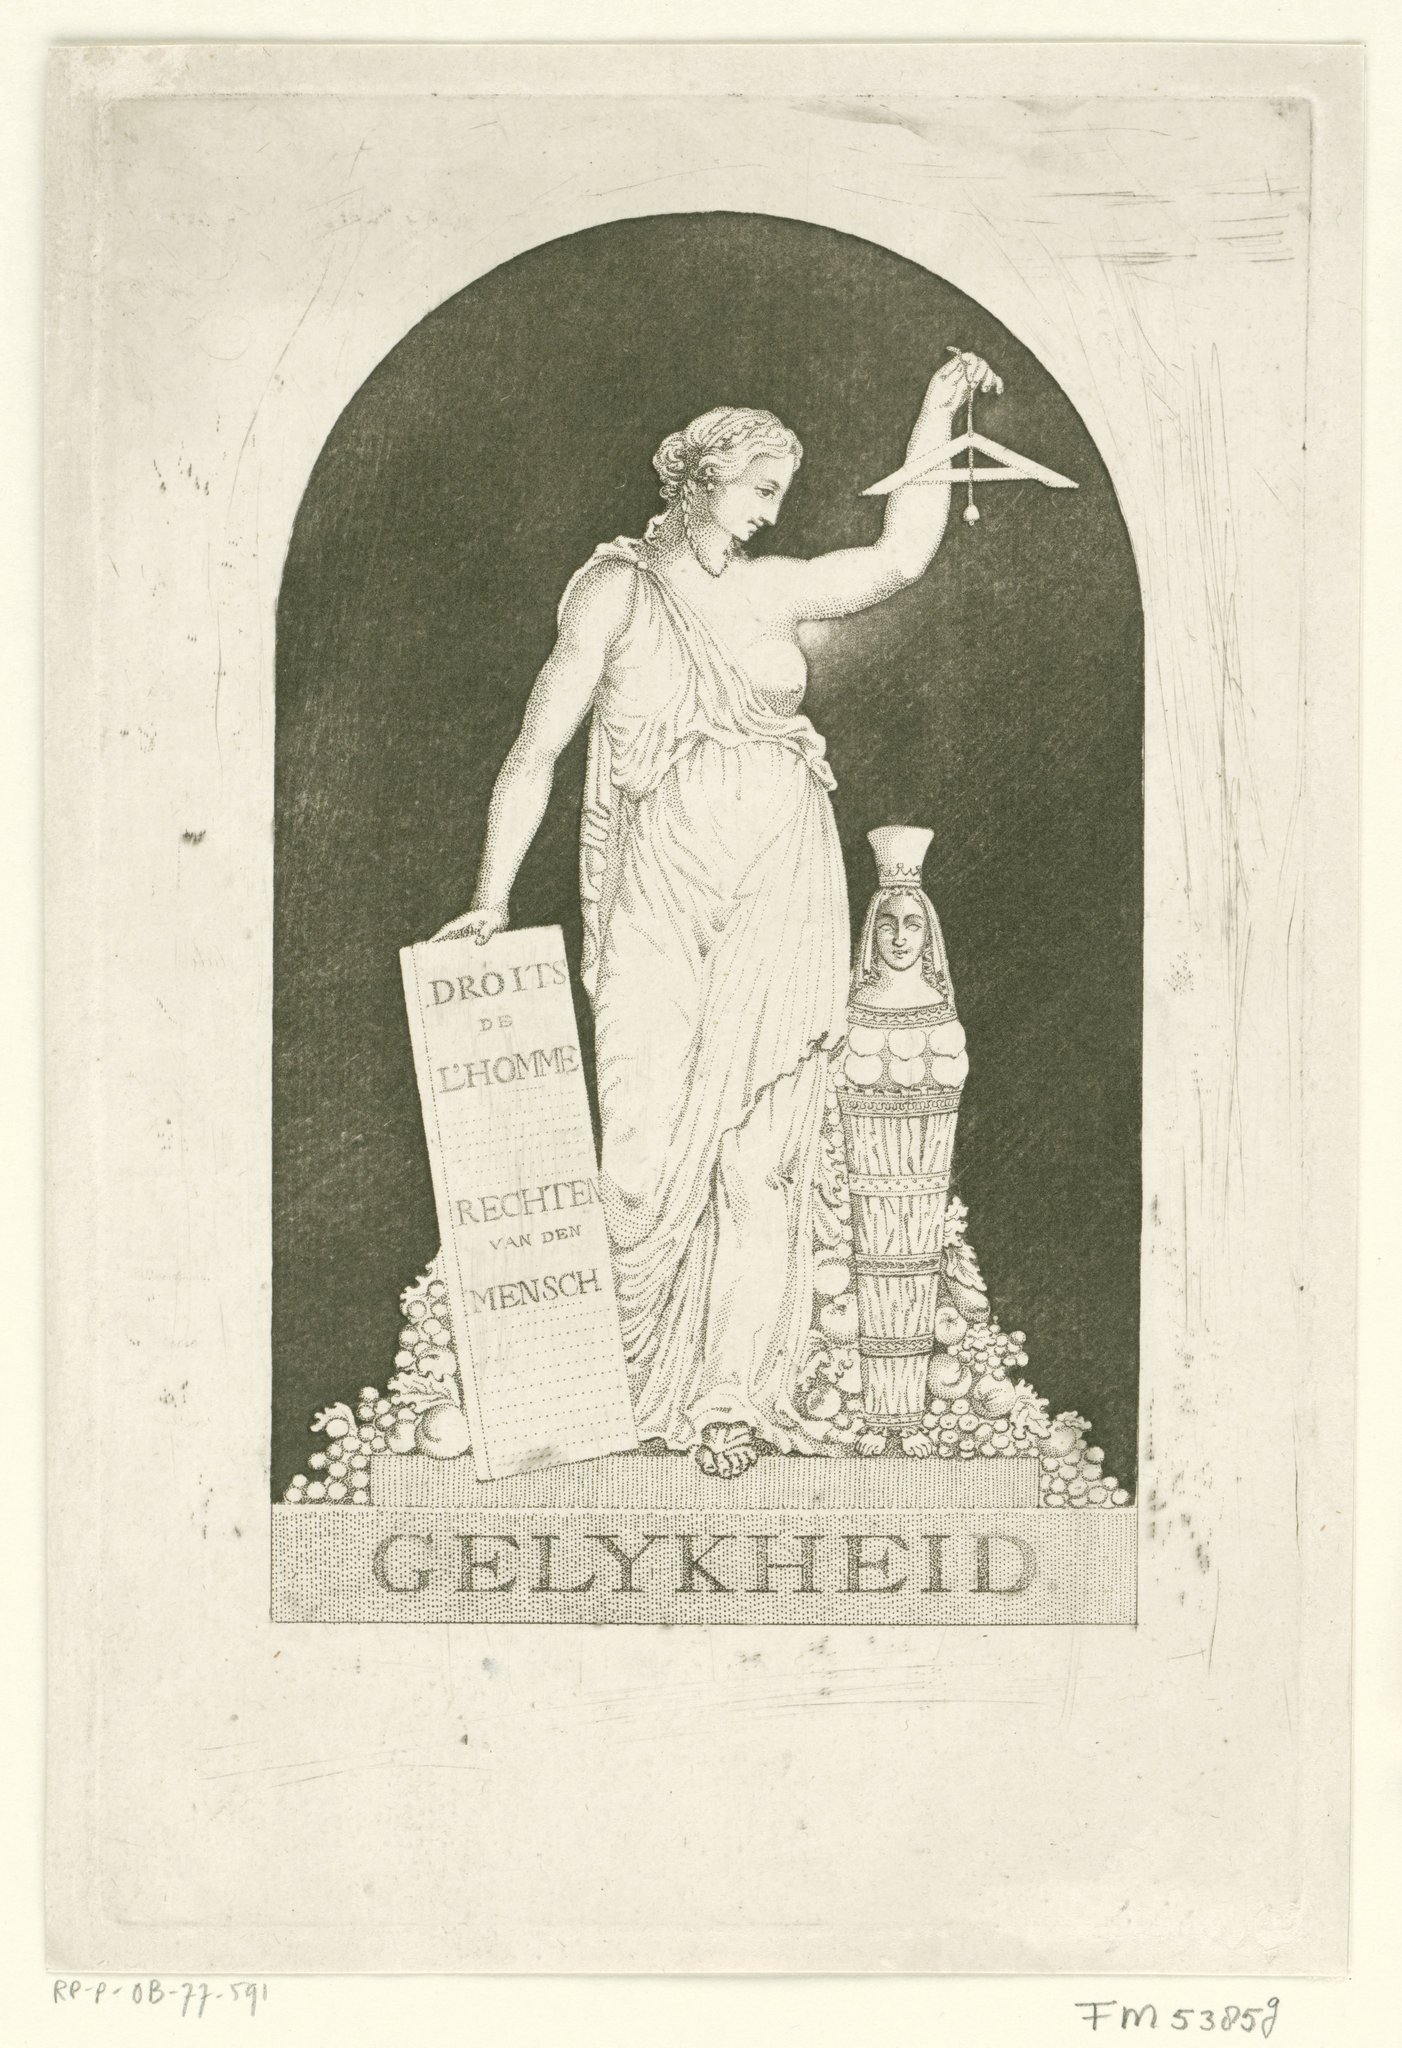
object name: print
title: Gelykheid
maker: Anonymous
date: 1795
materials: paper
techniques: stippled etching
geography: netherlands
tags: equality, equity, fairness, righteousness; 'equalità', 'equità', 'giuditio giusto', 'ordine dritto e giusto', 'ugualità' (ripa) (+ abstract concept represented by female figure)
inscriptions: collector's mark: Lugt 2228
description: Personificatie van de Gelijkheid met een tablet met de tekst 'Droits de l'Homme, Rechten van den Mensch', in de andere hand een paslood, verder symbolen van overvloed, ca. 1795.